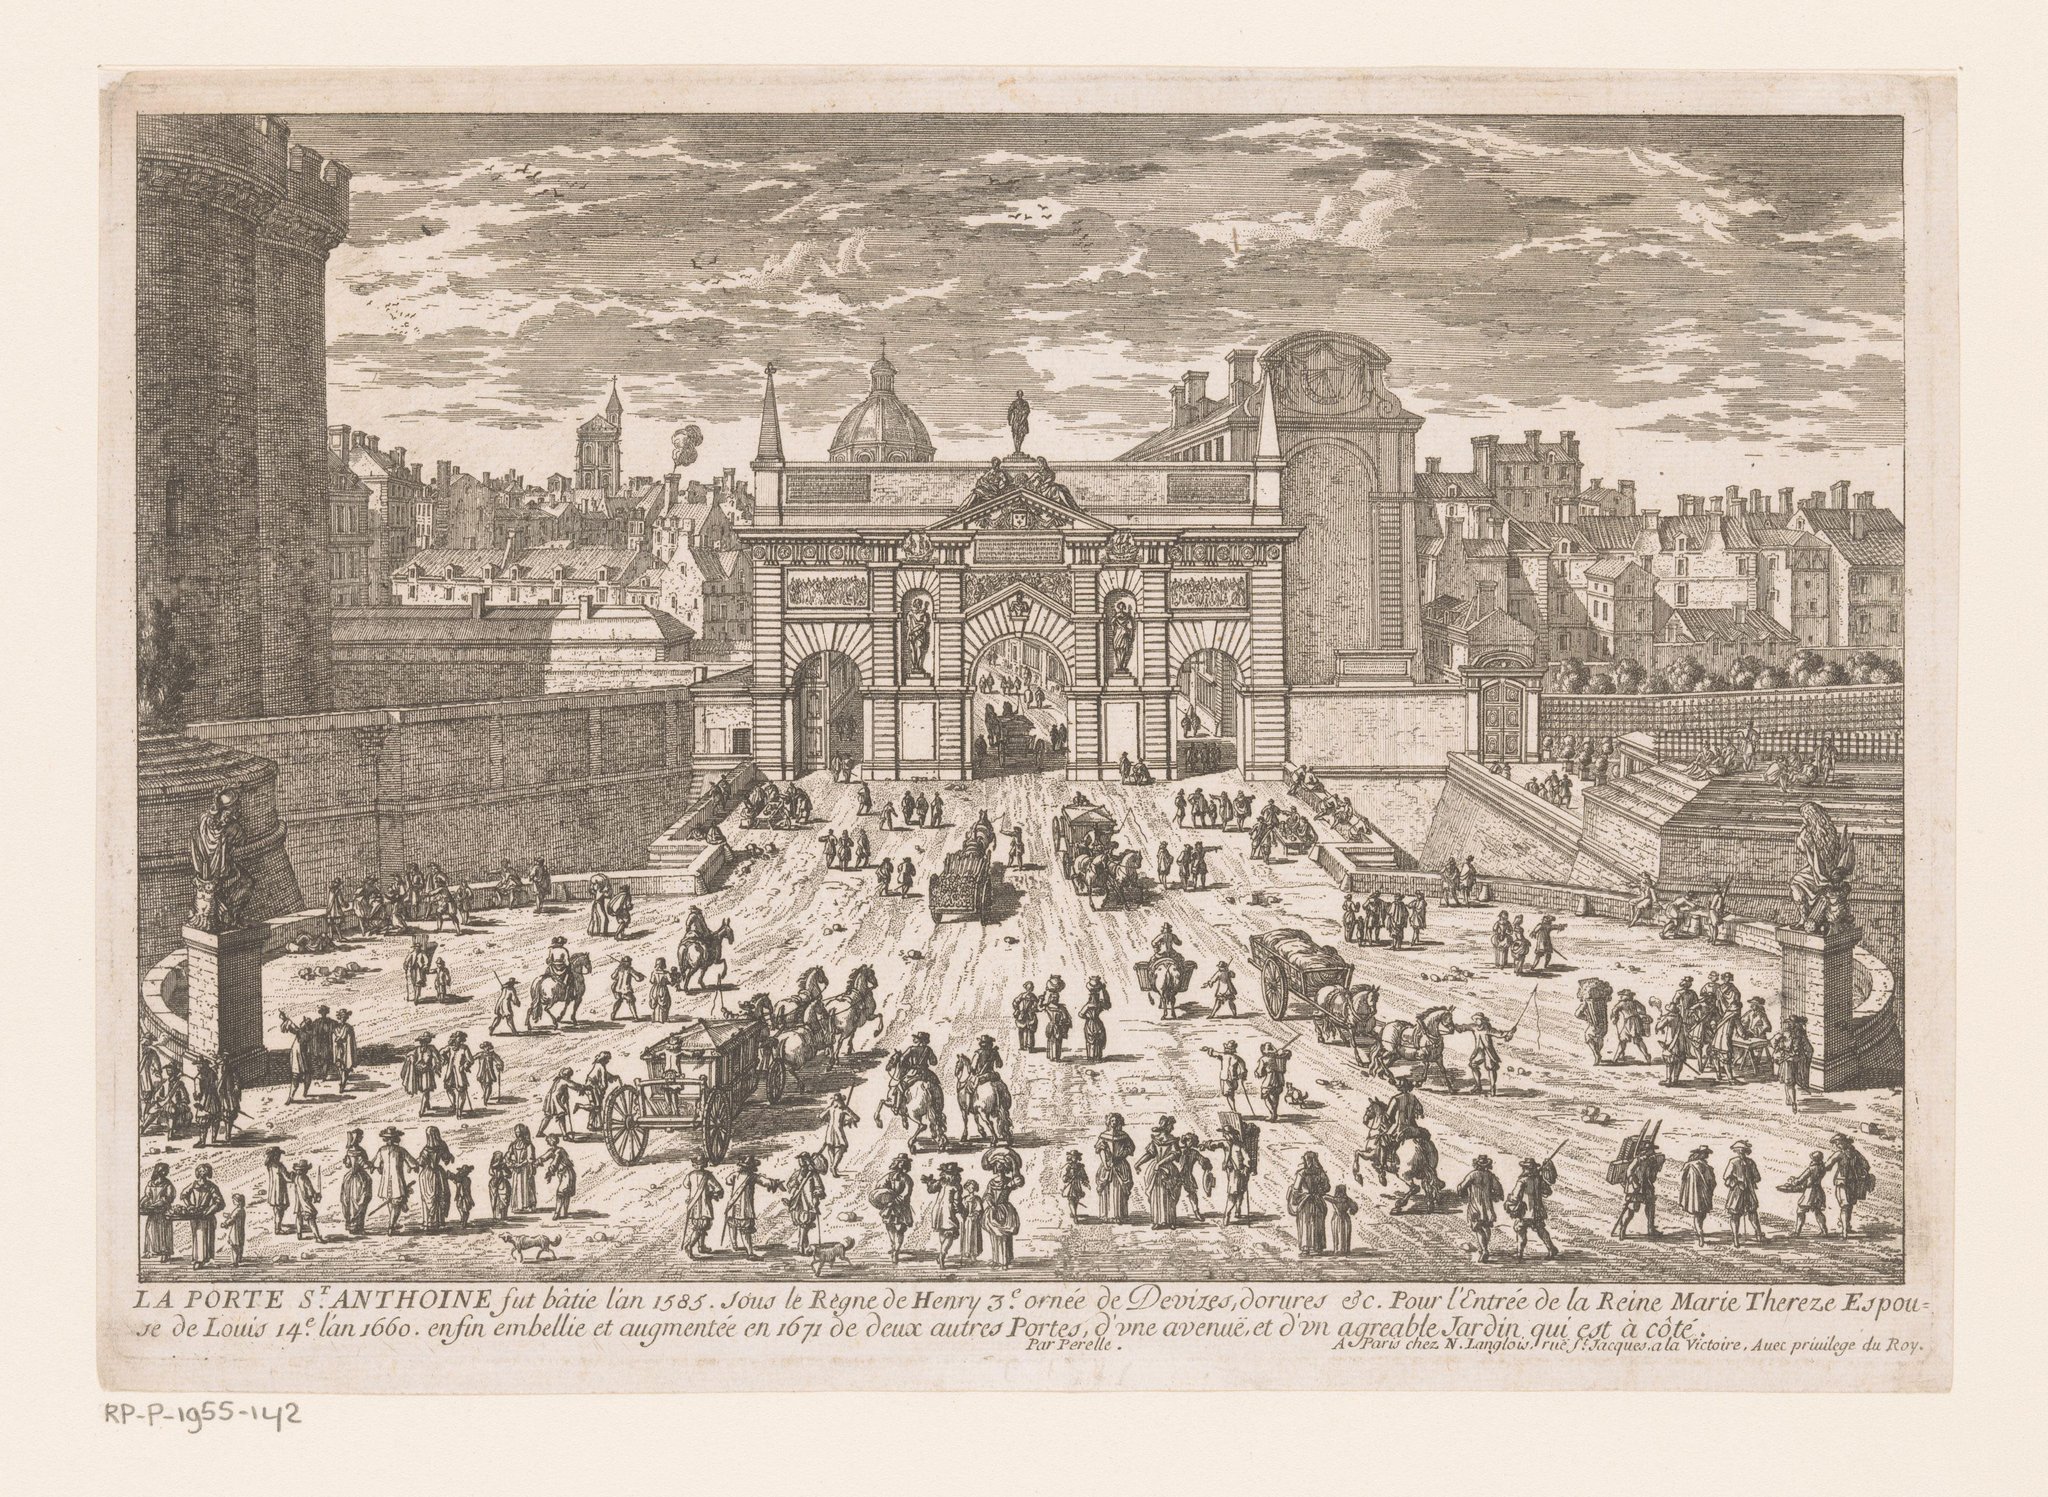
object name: print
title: Gezicht op de Porte Saint-Antoine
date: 1671-1695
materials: paper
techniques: etching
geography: france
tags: city-gate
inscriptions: collector's mark: Lugt 2228